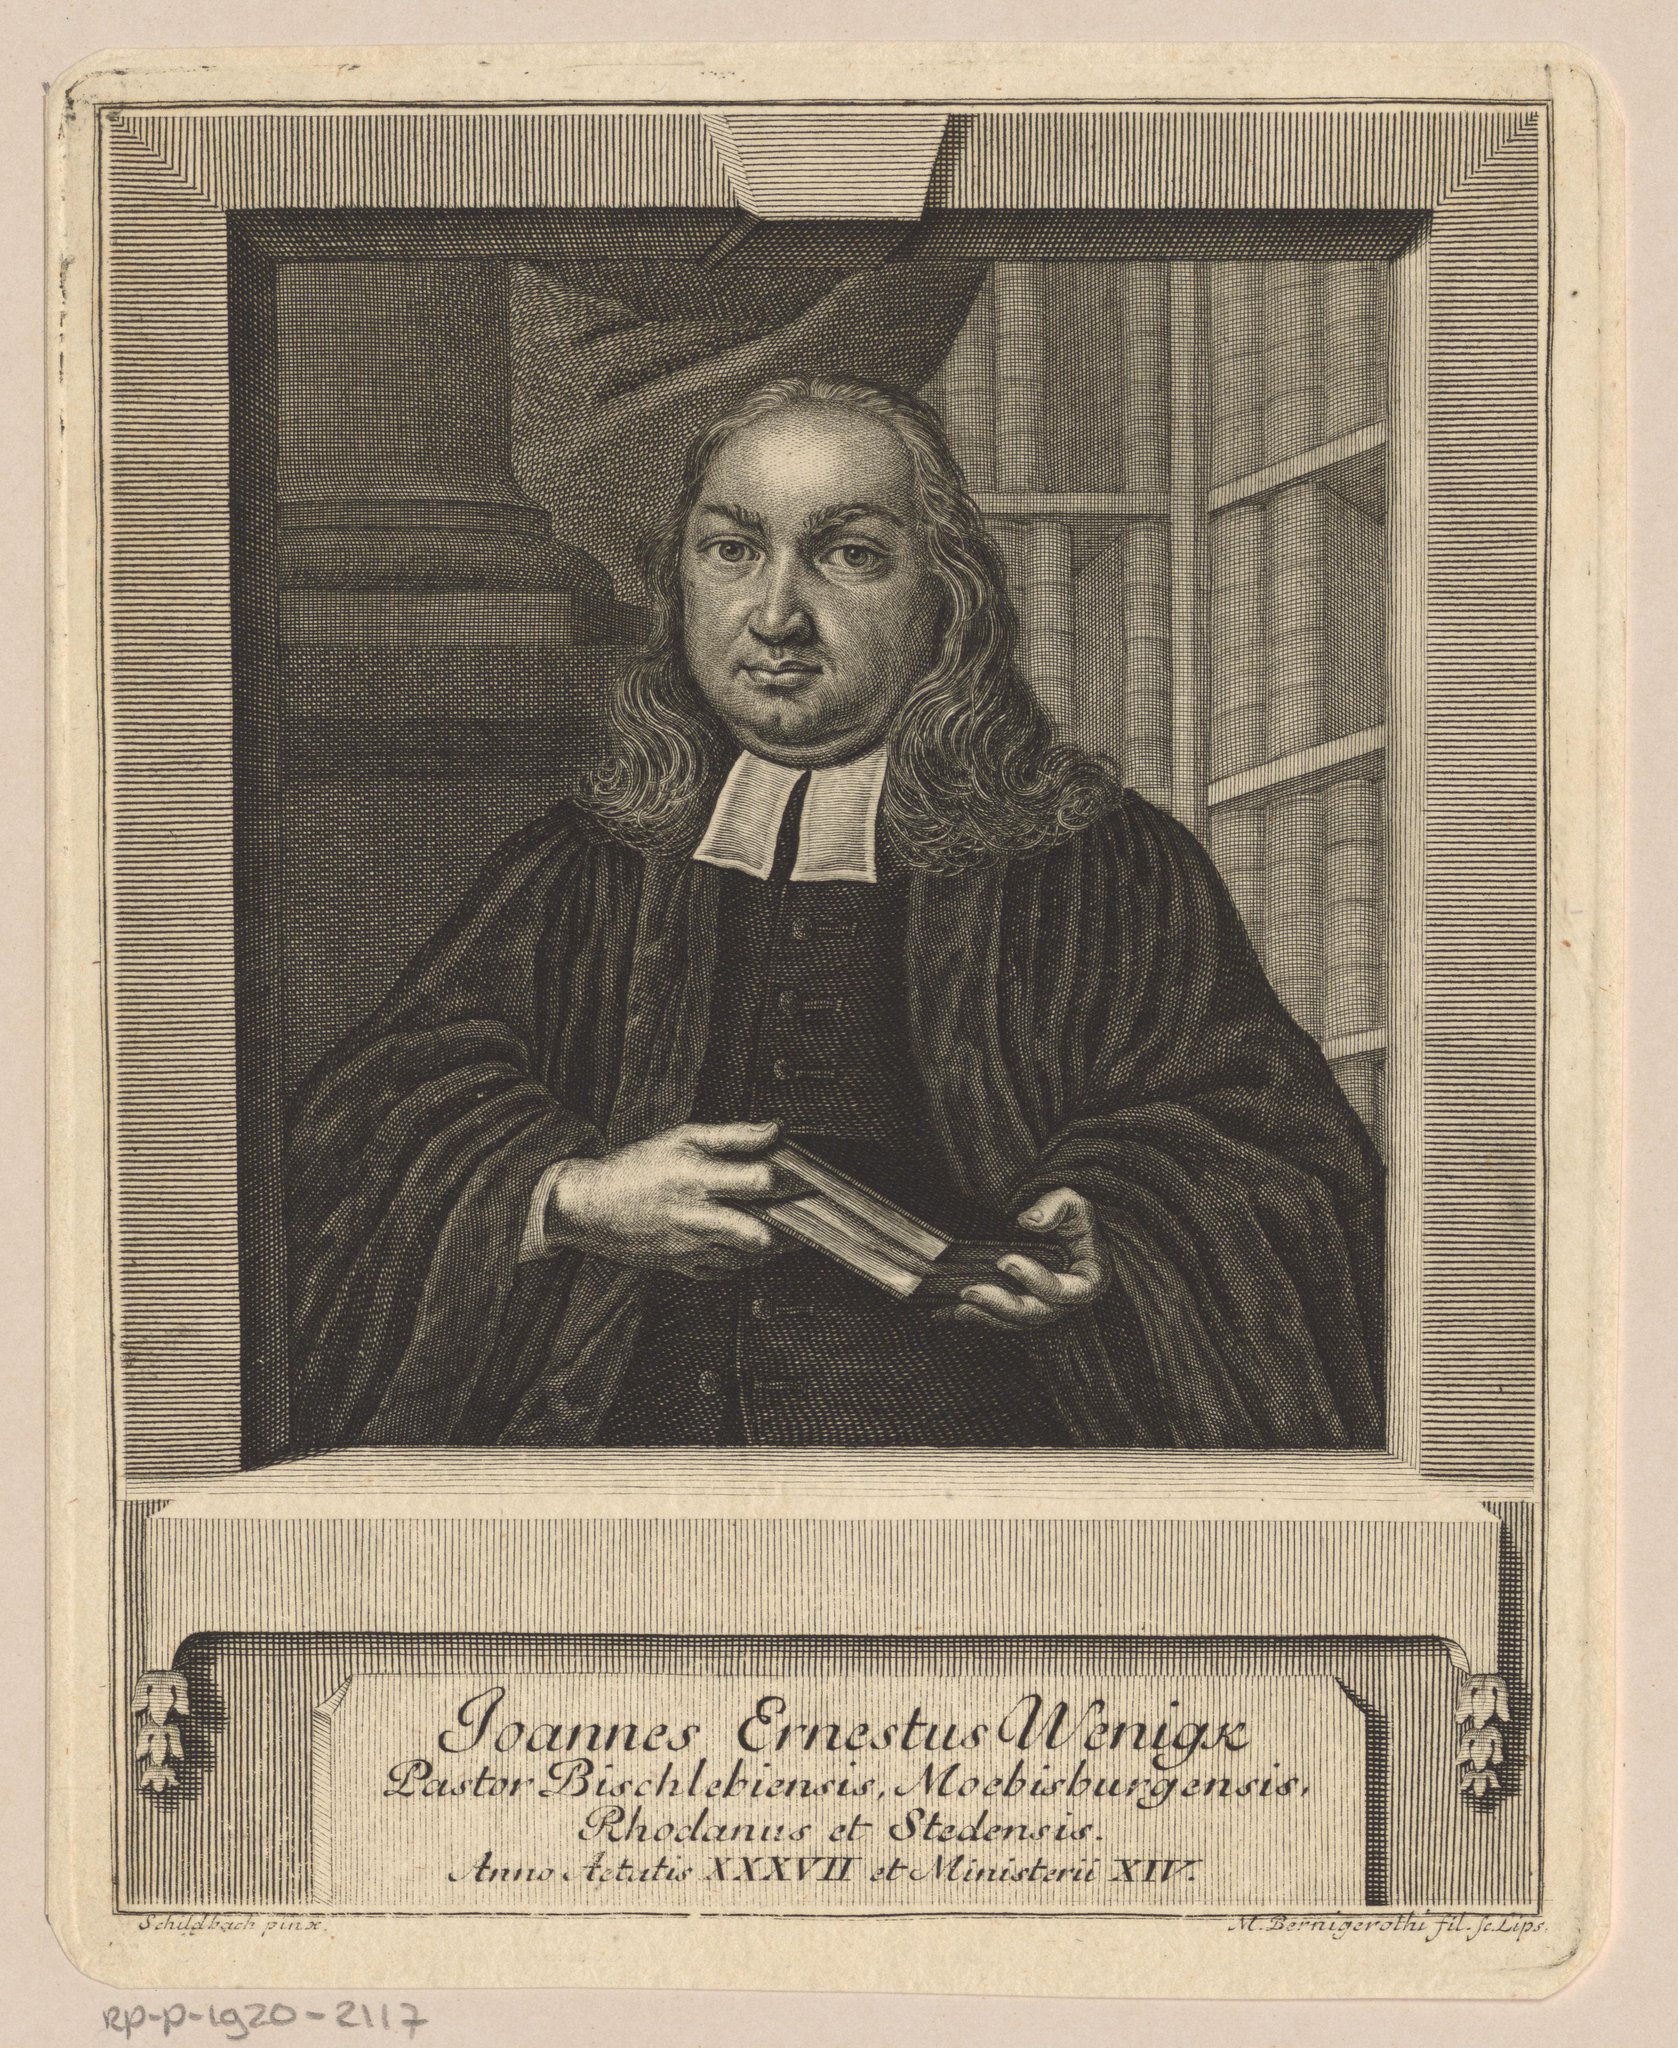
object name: print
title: Portret van Johann Ernst Wenigk op 37-jarige leeftijd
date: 1739-1767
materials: paper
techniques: engraving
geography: leipzig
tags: bookshelves, historical persons, book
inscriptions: collector's mark: Lugt 2228